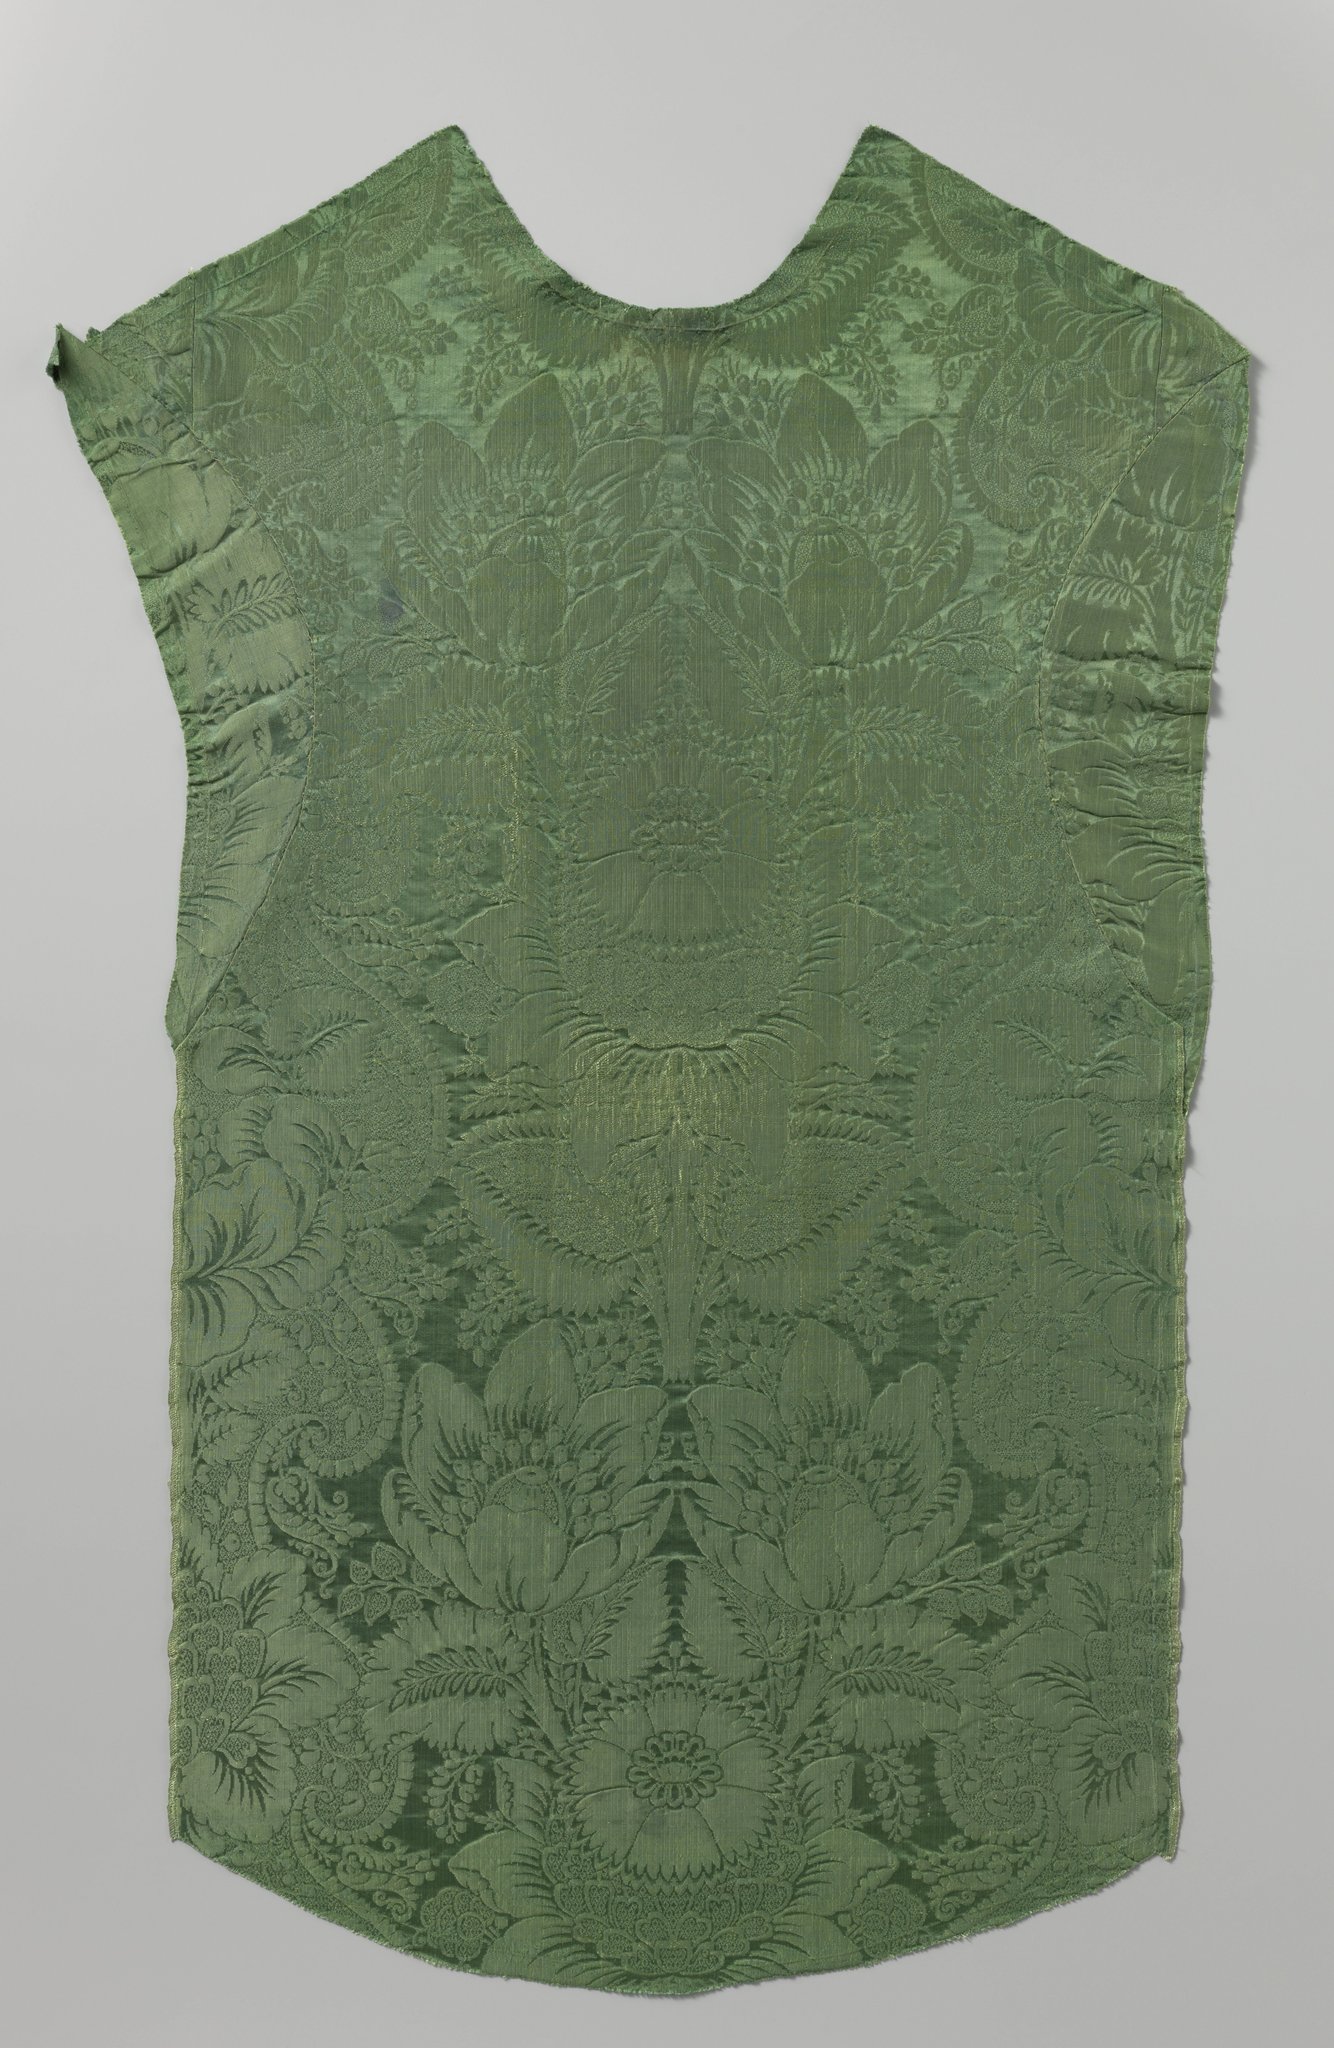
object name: zijdedamast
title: Fragment groen zijdedamast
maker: Anonymous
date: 1700-1725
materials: silk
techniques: damask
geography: france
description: Drie fragmenten van groen zijden damast. Het patroon bestaat uit een grote zonnebloem met twee papavers bijeengebonden ter weerszijden waarvan een slinger van grove kant. Oorspronkelijk een kazuifel.